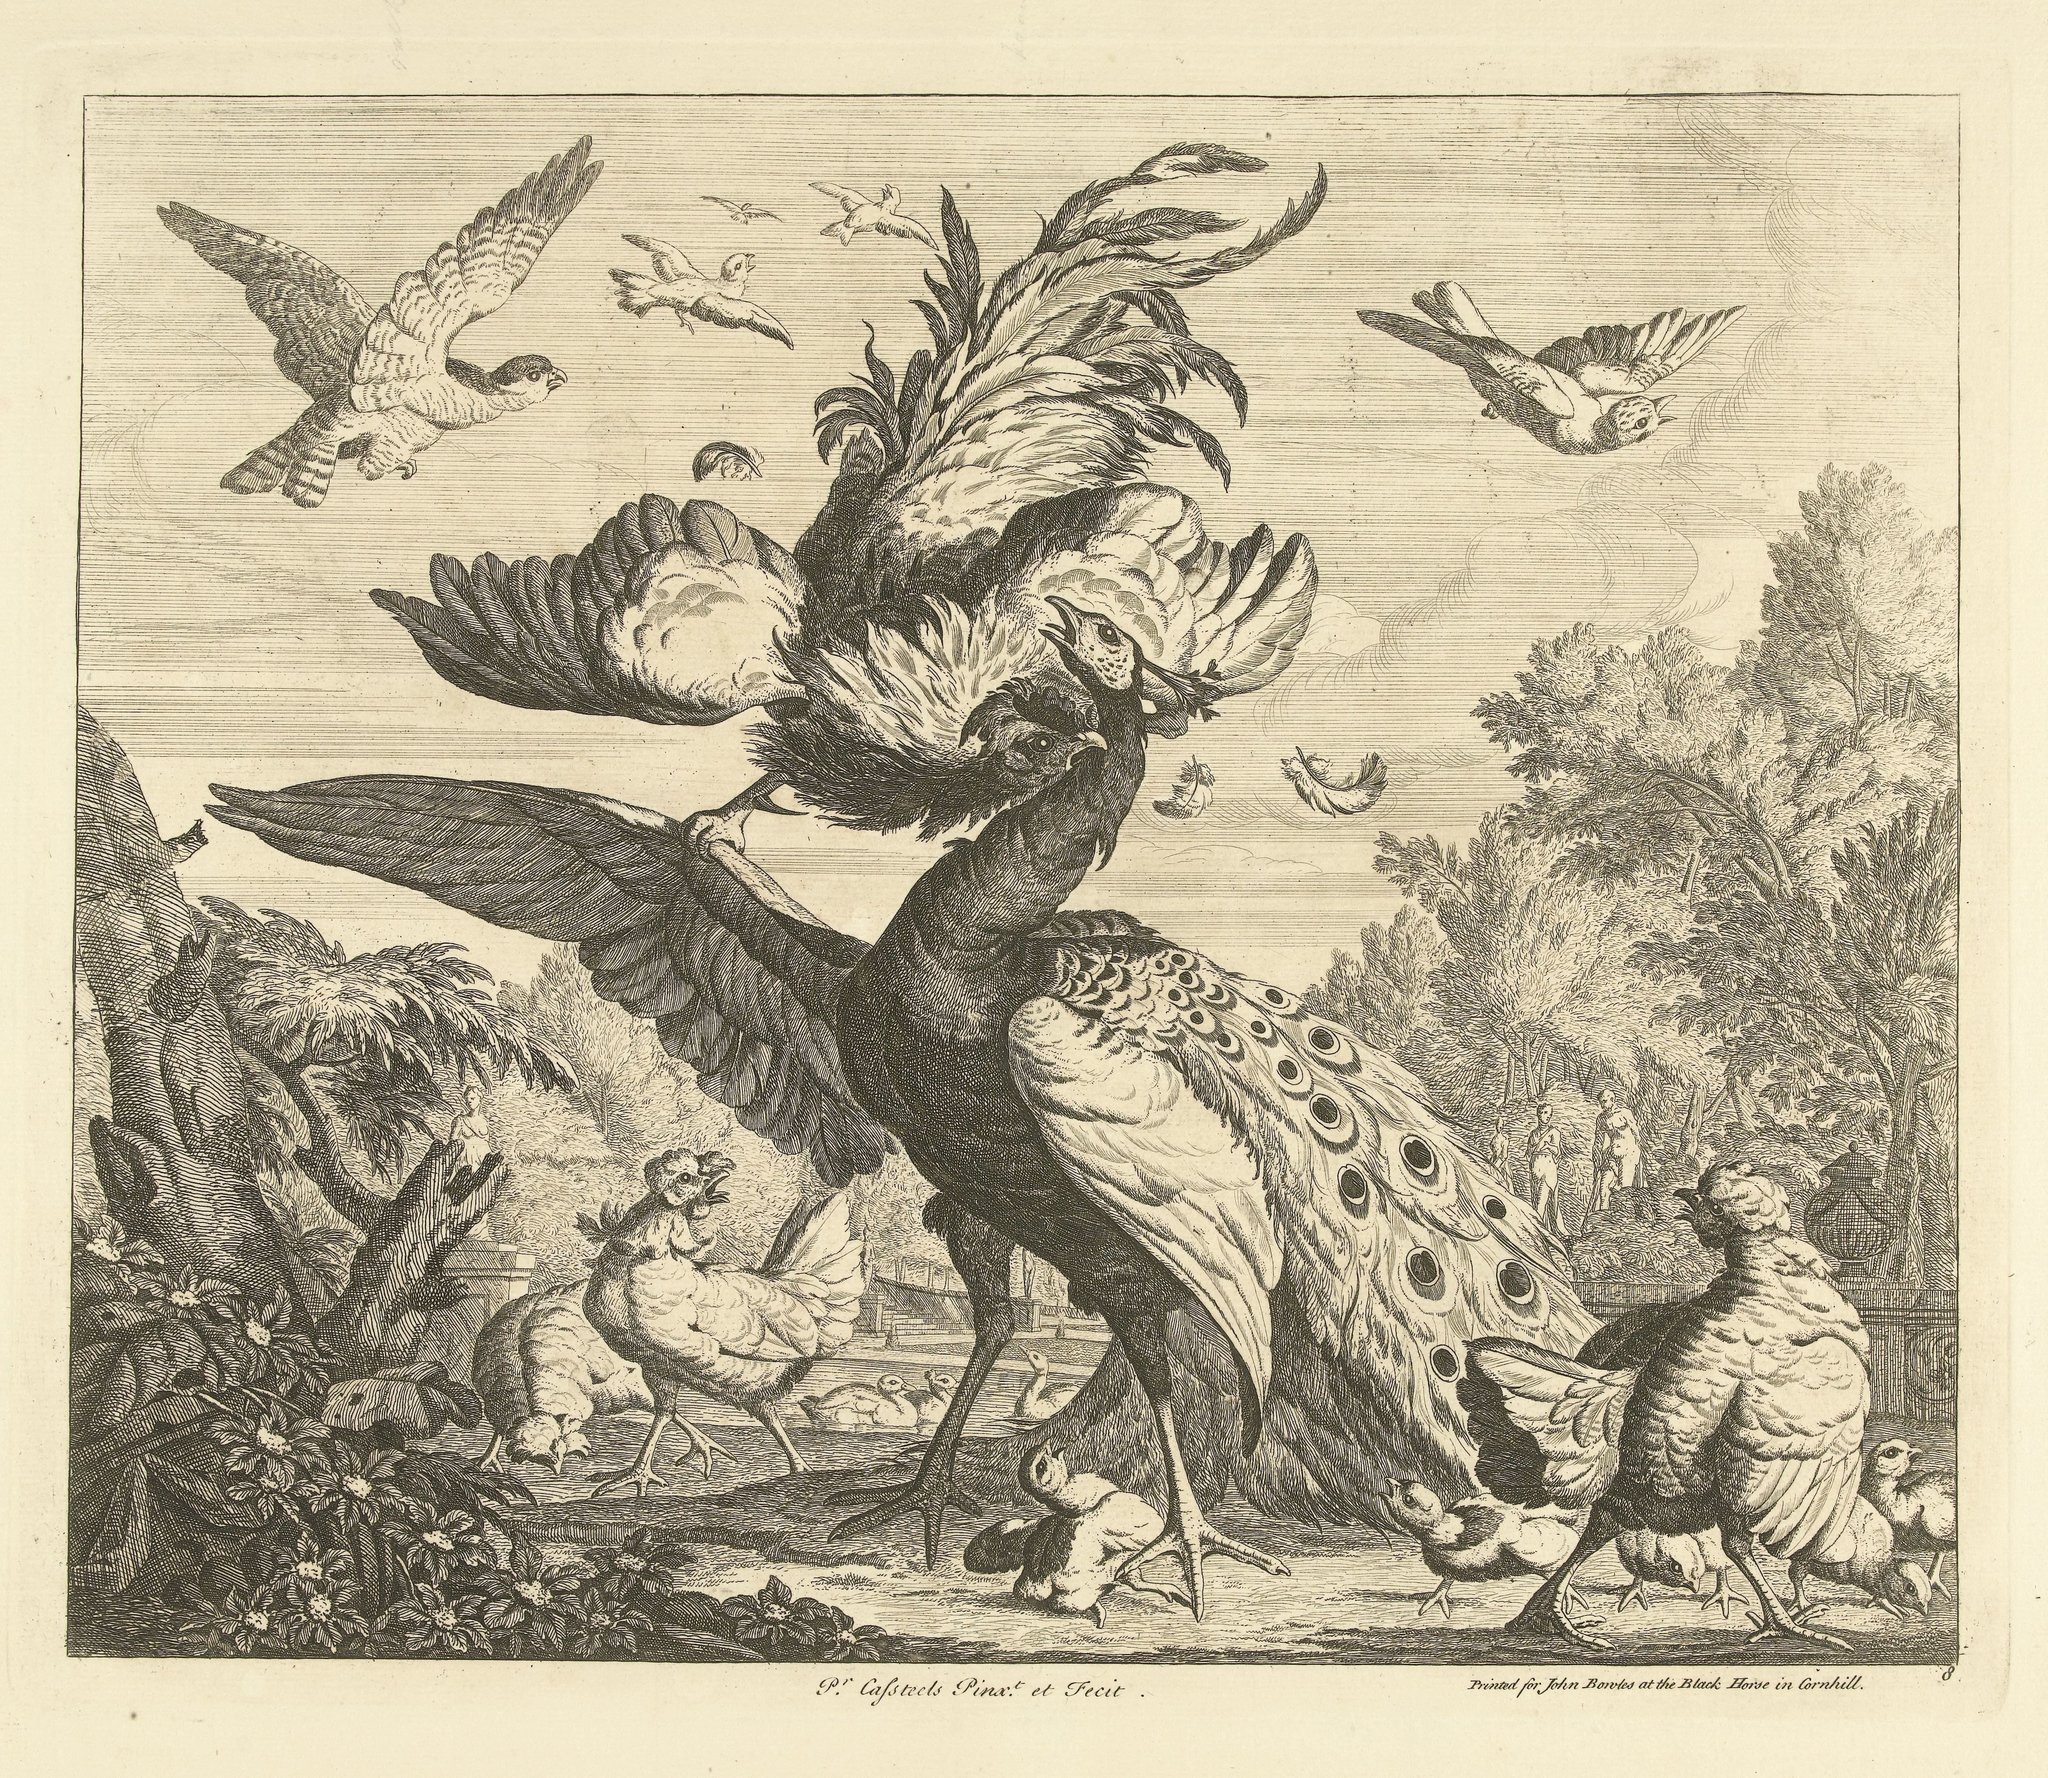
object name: print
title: Verschillende vogels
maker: peter casteels (iii)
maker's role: draughtsman, print maker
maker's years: 1684-1749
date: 1708-1749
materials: paper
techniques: etching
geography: london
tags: garden, ornamental birds: peacock, animals (+ fighting animals; aggressive relations), fowl (cock, hen, chicken, etc.)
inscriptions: collector's mark: Lugt 2228